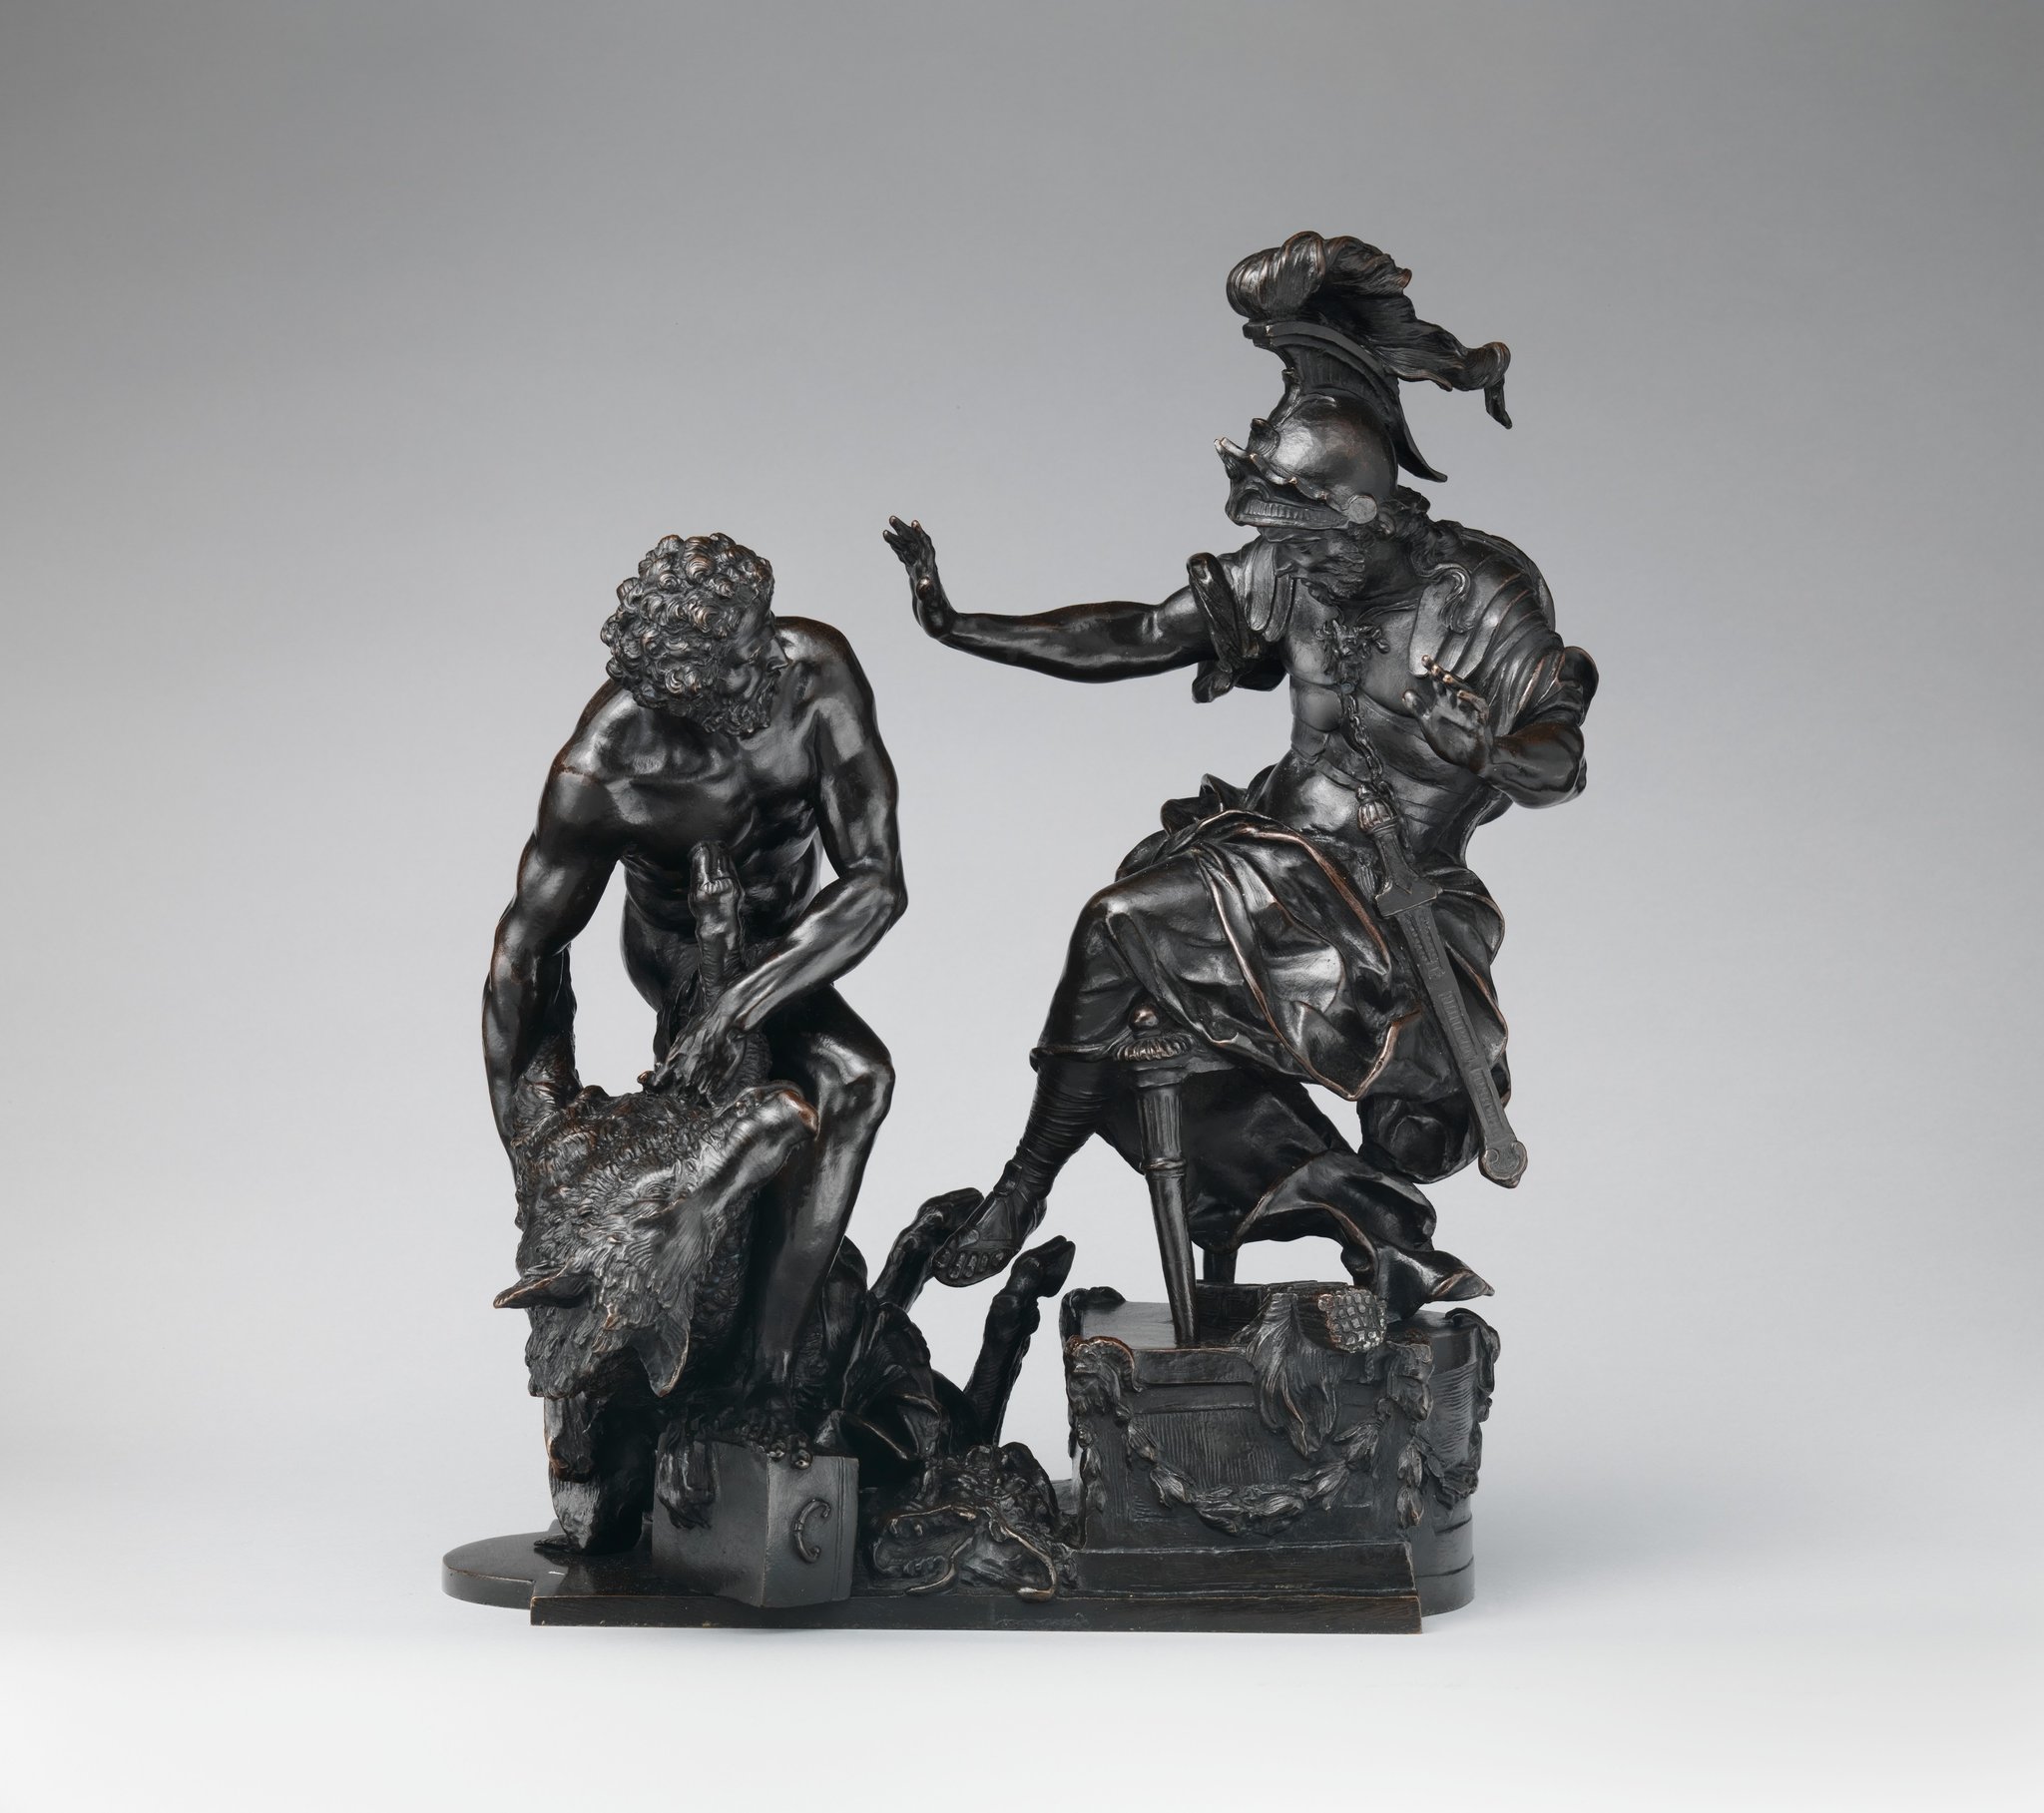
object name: statuette group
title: Hercules Delivering the Erymanthean Boar to Eurystheus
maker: françois lespingola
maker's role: artist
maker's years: 1644-1705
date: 1676-1700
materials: bronze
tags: kings,hercules,boars